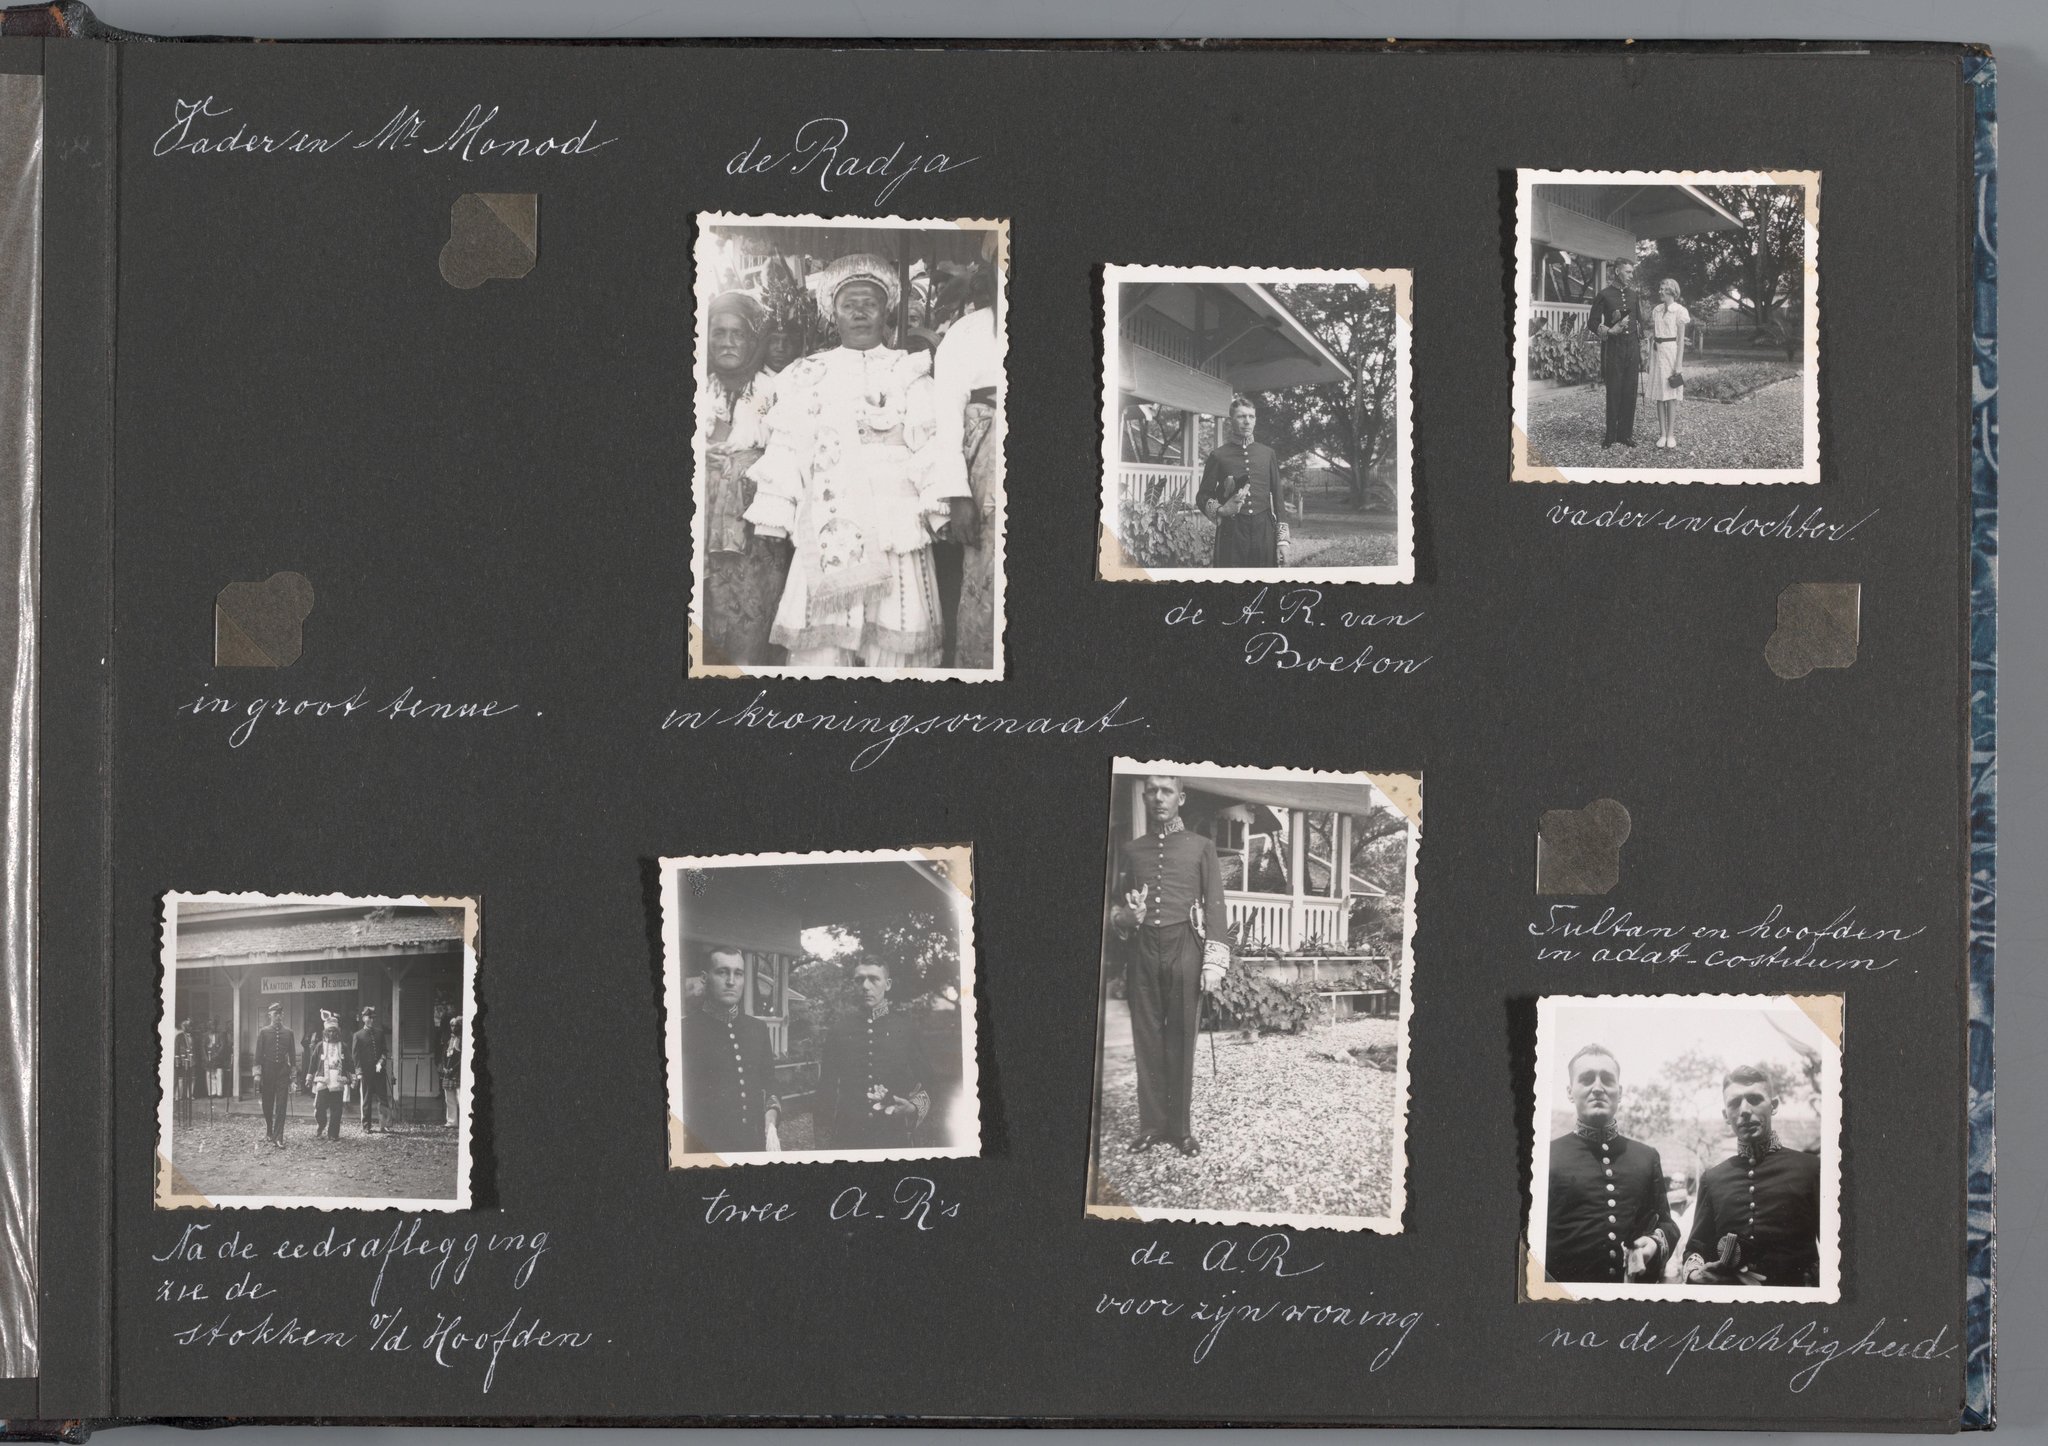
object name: photograph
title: Installatie van de Sultan van Boeton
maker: Anonymous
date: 1938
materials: cardboard, photographic support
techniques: gelatin silver print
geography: celebes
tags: jet vonk, r.h. vonk, ceremonial celebration of installation of a ruler, colonial government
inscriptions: inscription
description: Albumblad met zeven foto's (en twee lege plekken) elk met bijschrift, waarop o.a. assistent-resident Vonk, assistent-resident Monod de Froideville en de radja (Sultan van Boeton) in kroningsgewaad in 1938. Ter gelegenheid van de installatie van de nieuwe sultan van Boeton in 1938. Onderdeel van het familiealbum van Jet Vonk uit Celebes.